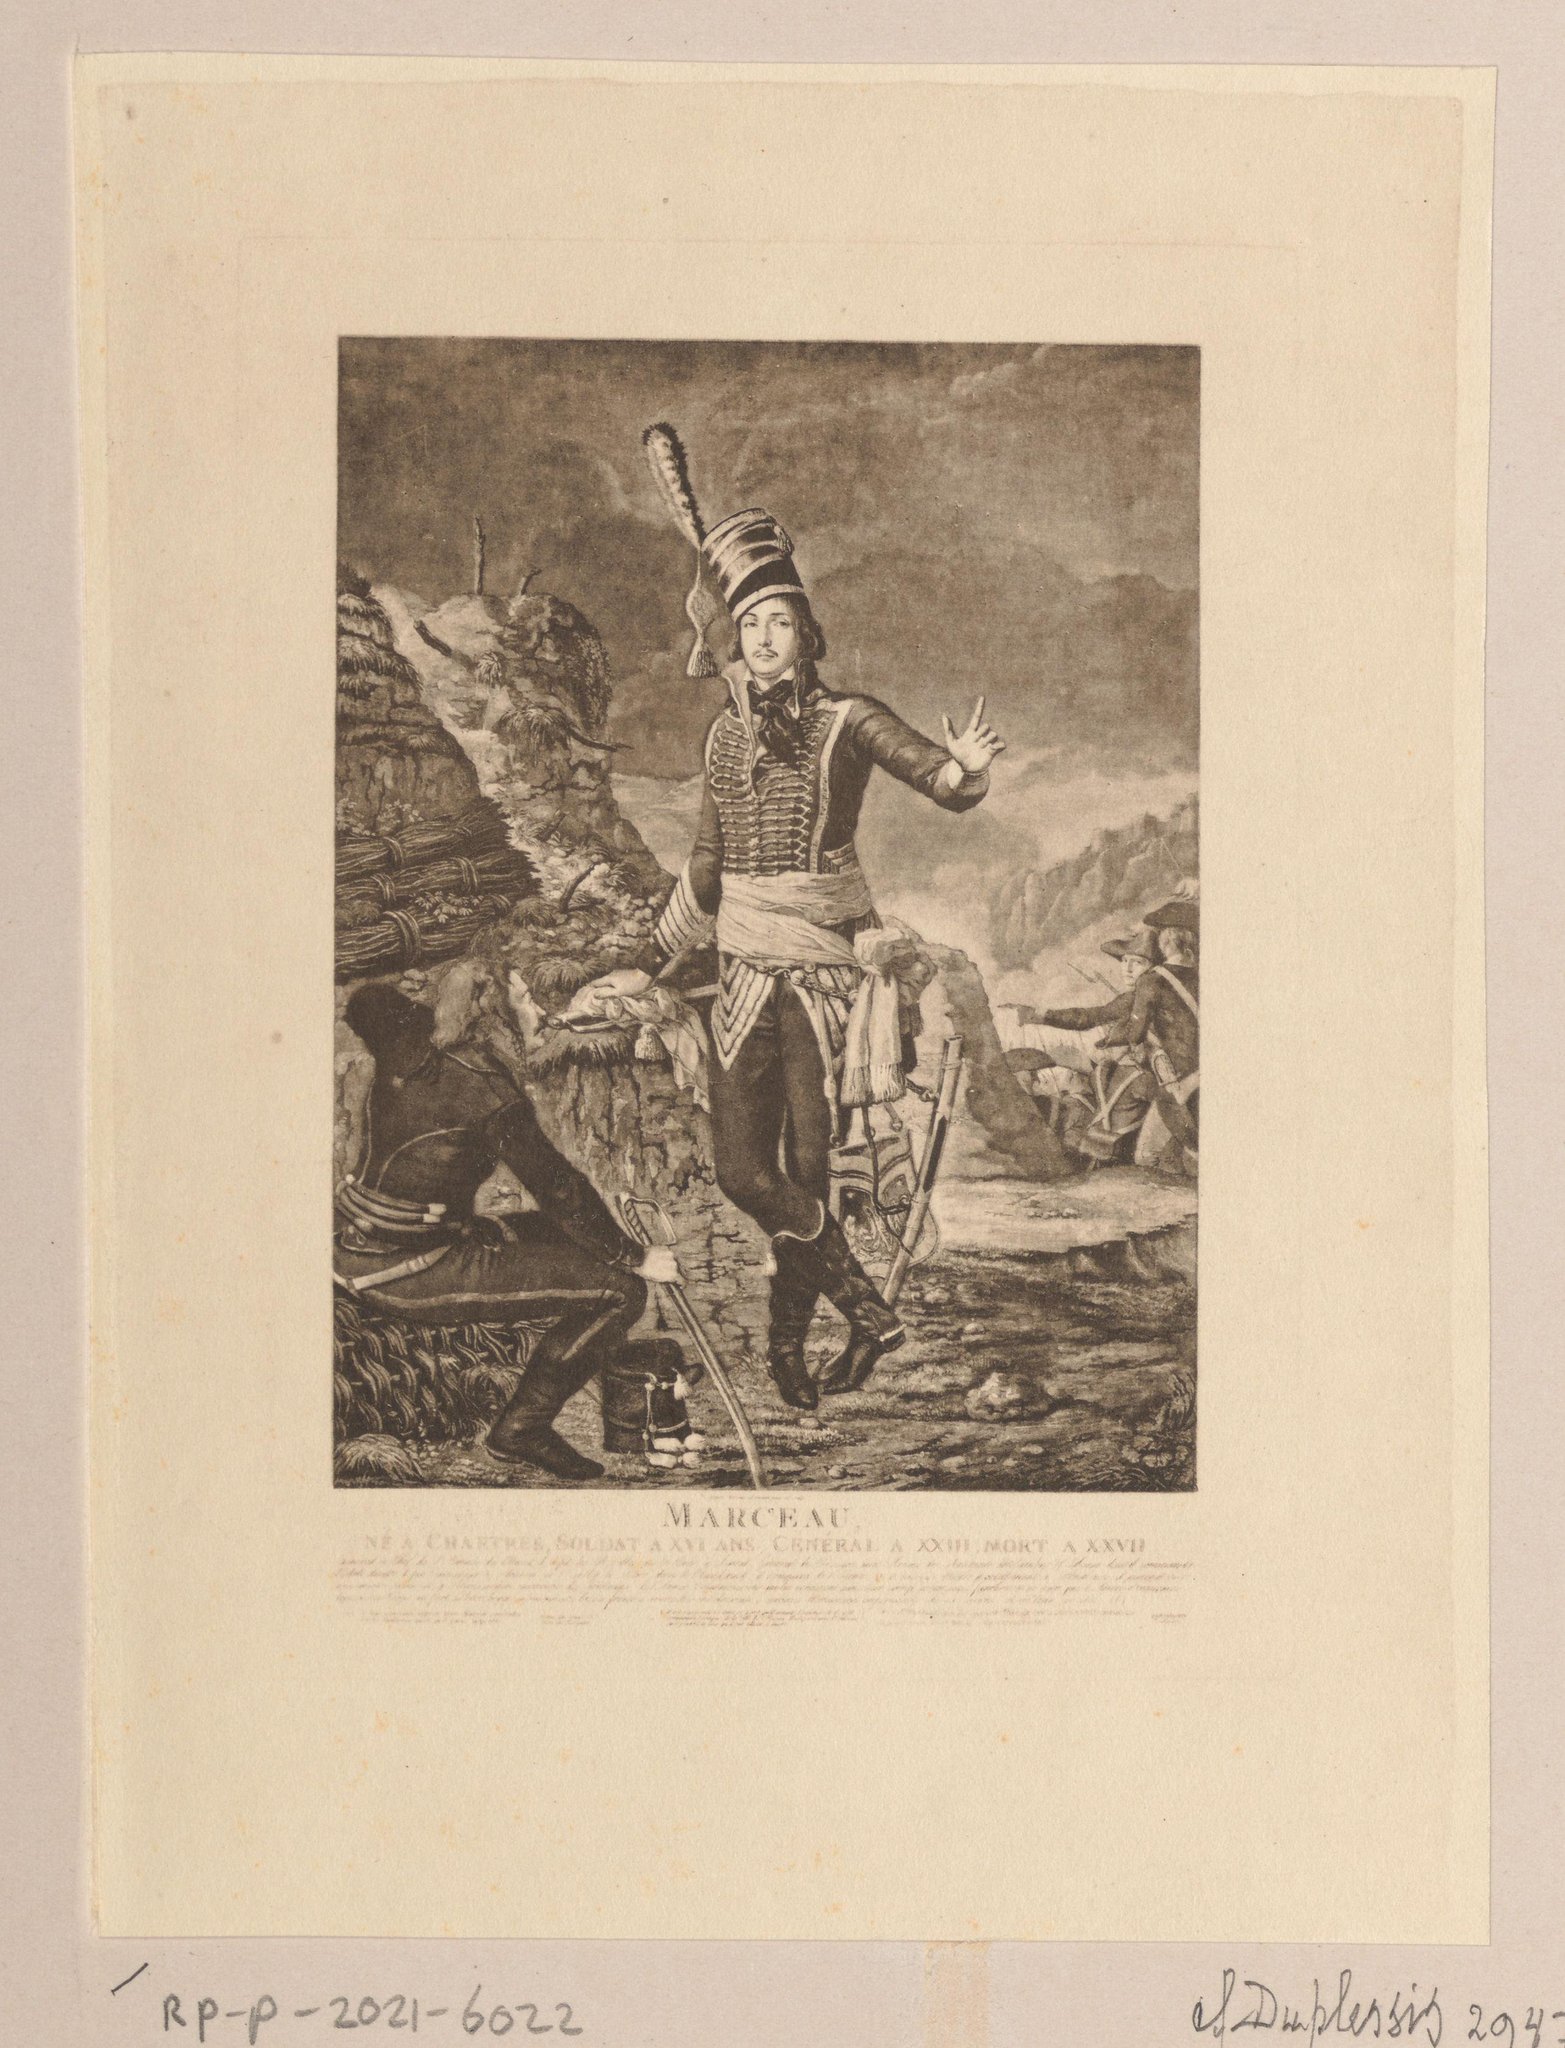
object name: photomechanical print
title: Portret van François Séverin Marceau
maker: Anonymous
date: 1875-1930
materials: paper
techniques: photograph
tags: commander-in-chief, general, marshal, historical persons, (military) uniforms